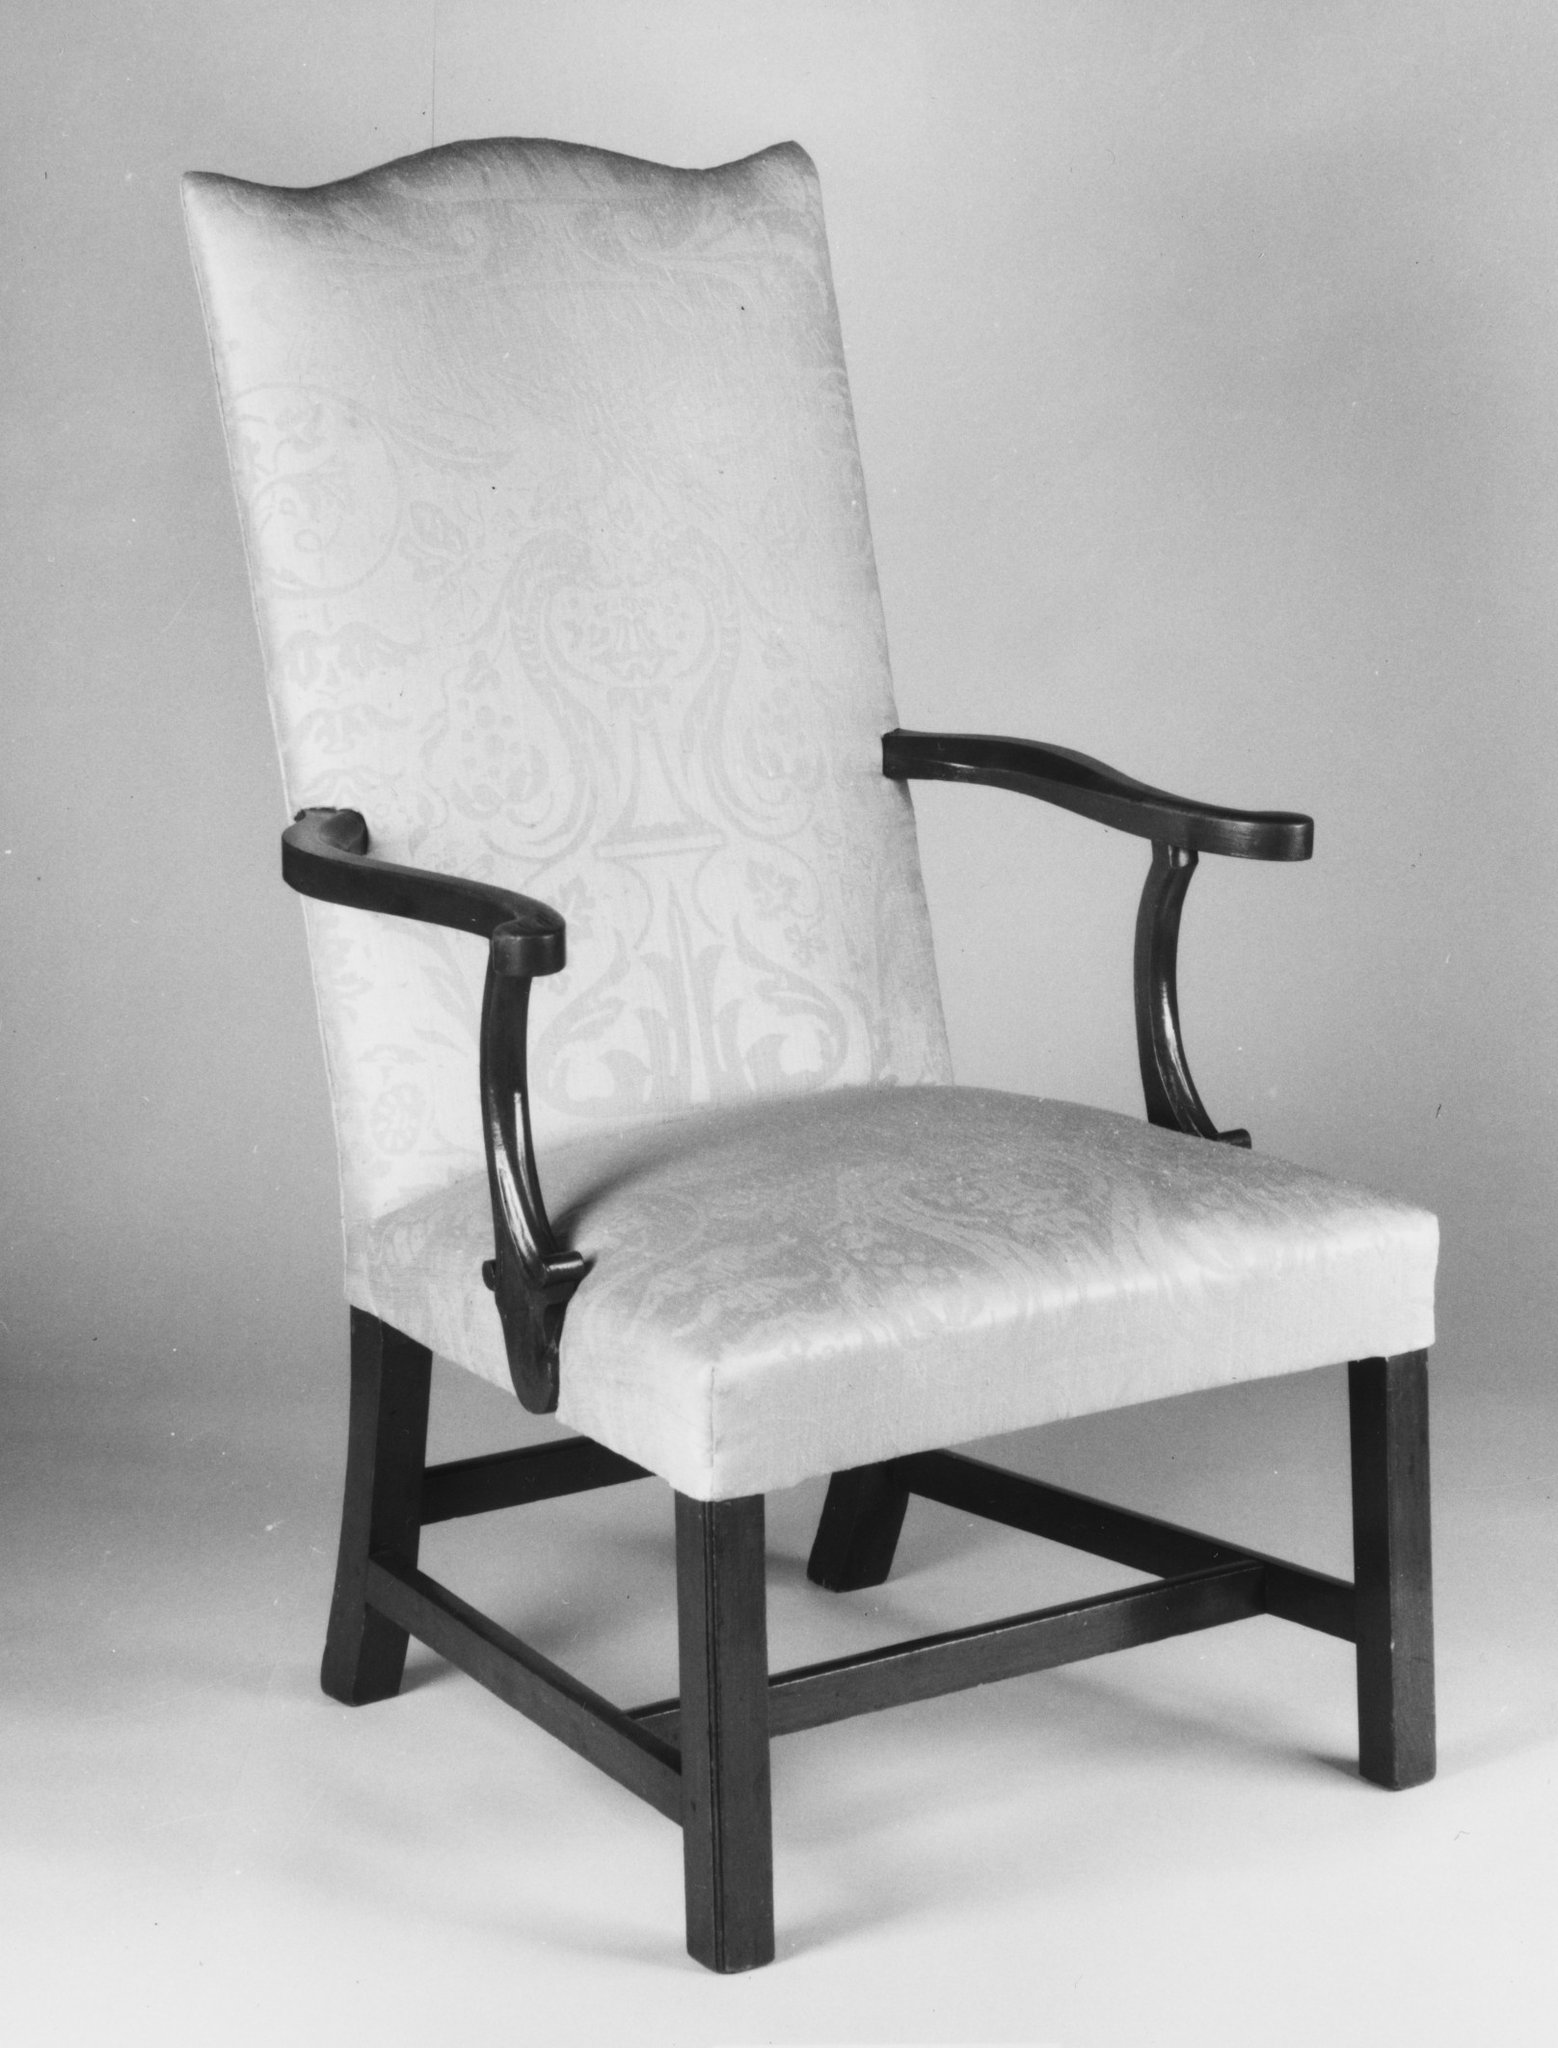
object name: lolling armchair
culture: american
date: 1790-1800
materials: wood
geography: united states